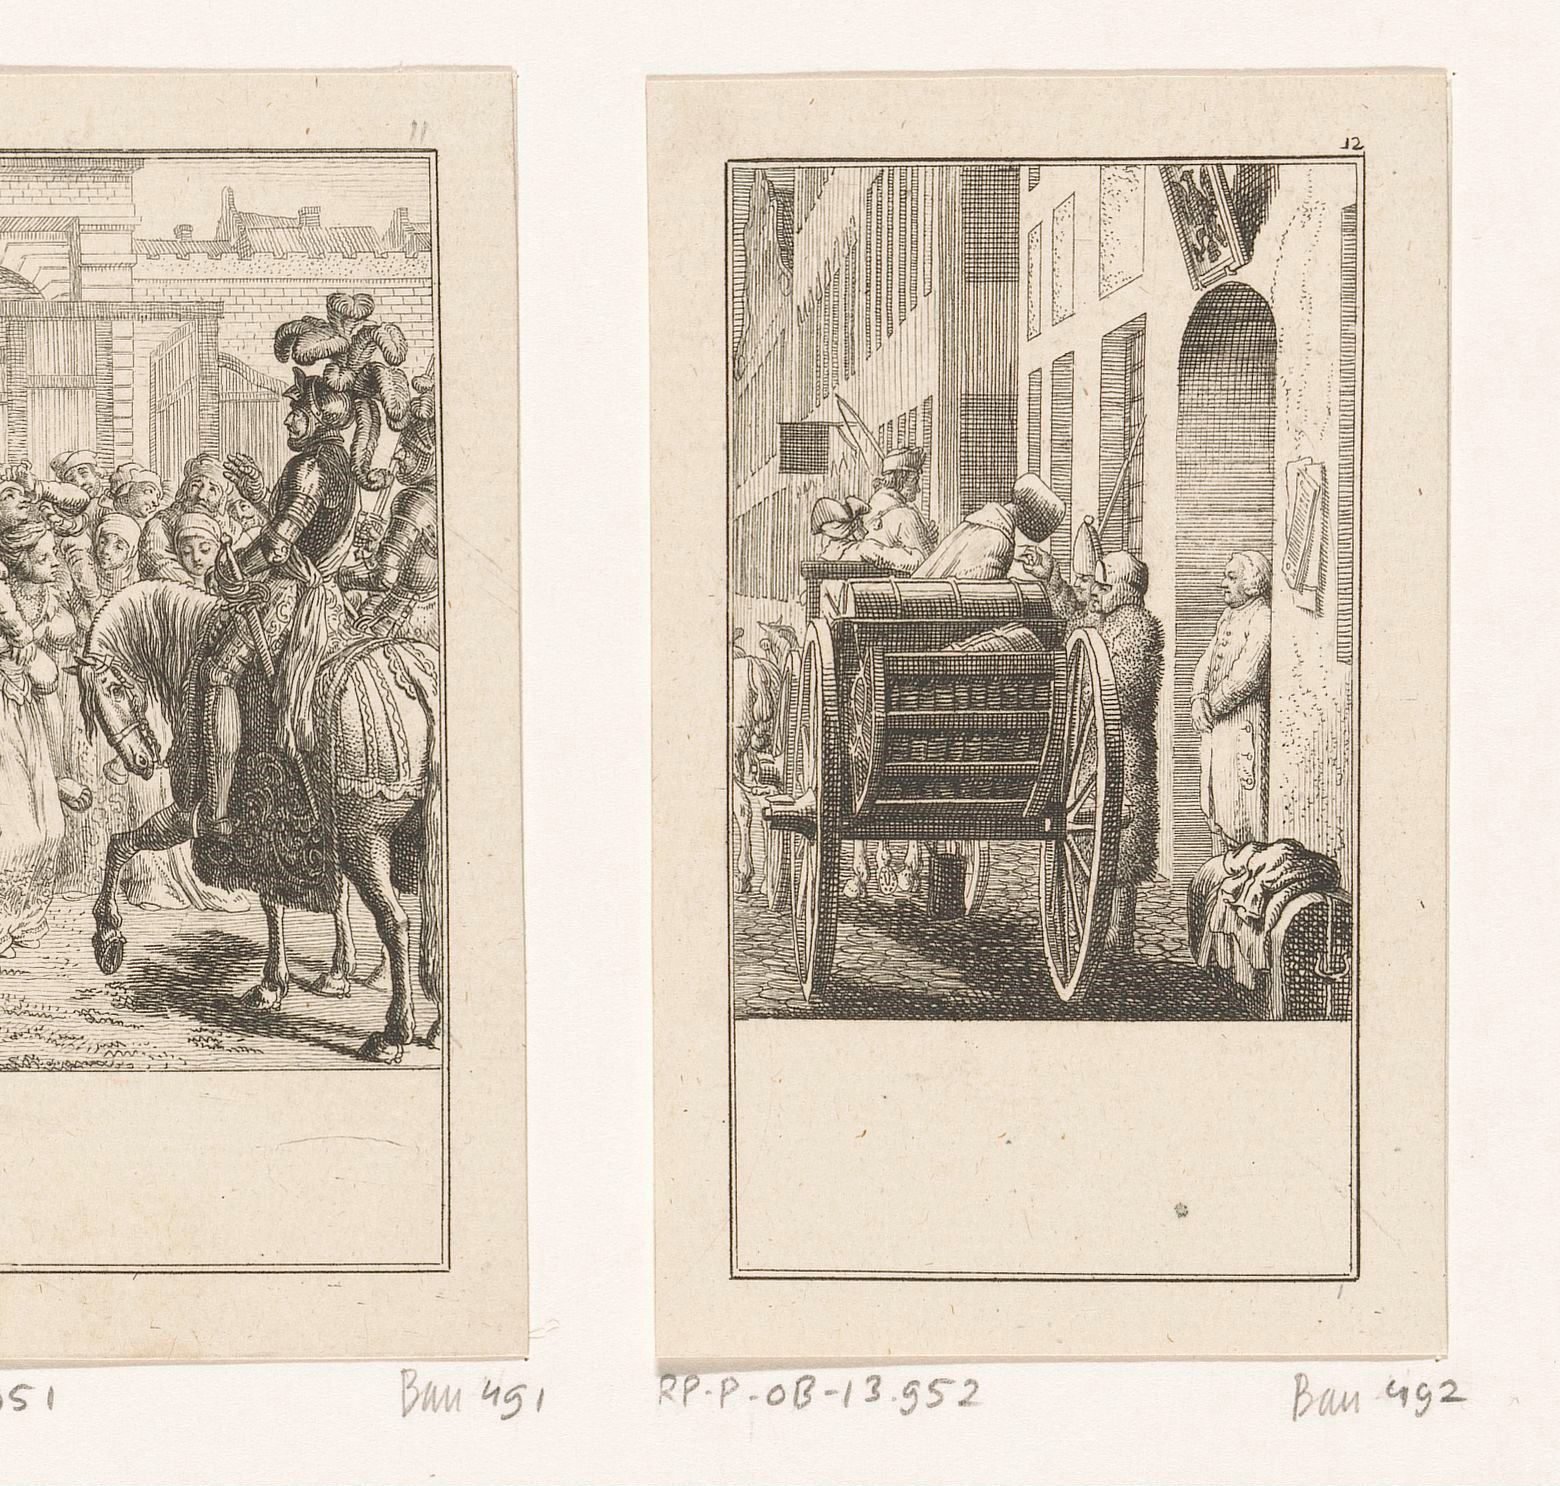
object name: print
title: Man helpt een vrouw uit een koets stappen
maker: daniel nikolaus chodowiecki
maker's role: draughtsman, print maker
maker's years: 1726-1801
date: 1778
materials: paper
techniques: etching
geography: berlin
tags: four-wheeled, animal-drawn vehicle, e.g.: cab, carriage, coach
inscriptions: collector's mark: Lugt 2228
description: Twaalfde prent uit een serie van twaalf moralistische en satirische voorstellingen. De scènes werden op een plaat geëtst. Een latere staat van deze is serie gebruikt in: Launburger genealogischen Kalender auf das Jahr 1779. Deze serie is een herhaling van een eerdere serie met onderschriften in het Duits (zie: RP-P-OB-13.938) en het Frans (zie: RP-P-OB-13.393 en RP-P-OB-13.940).